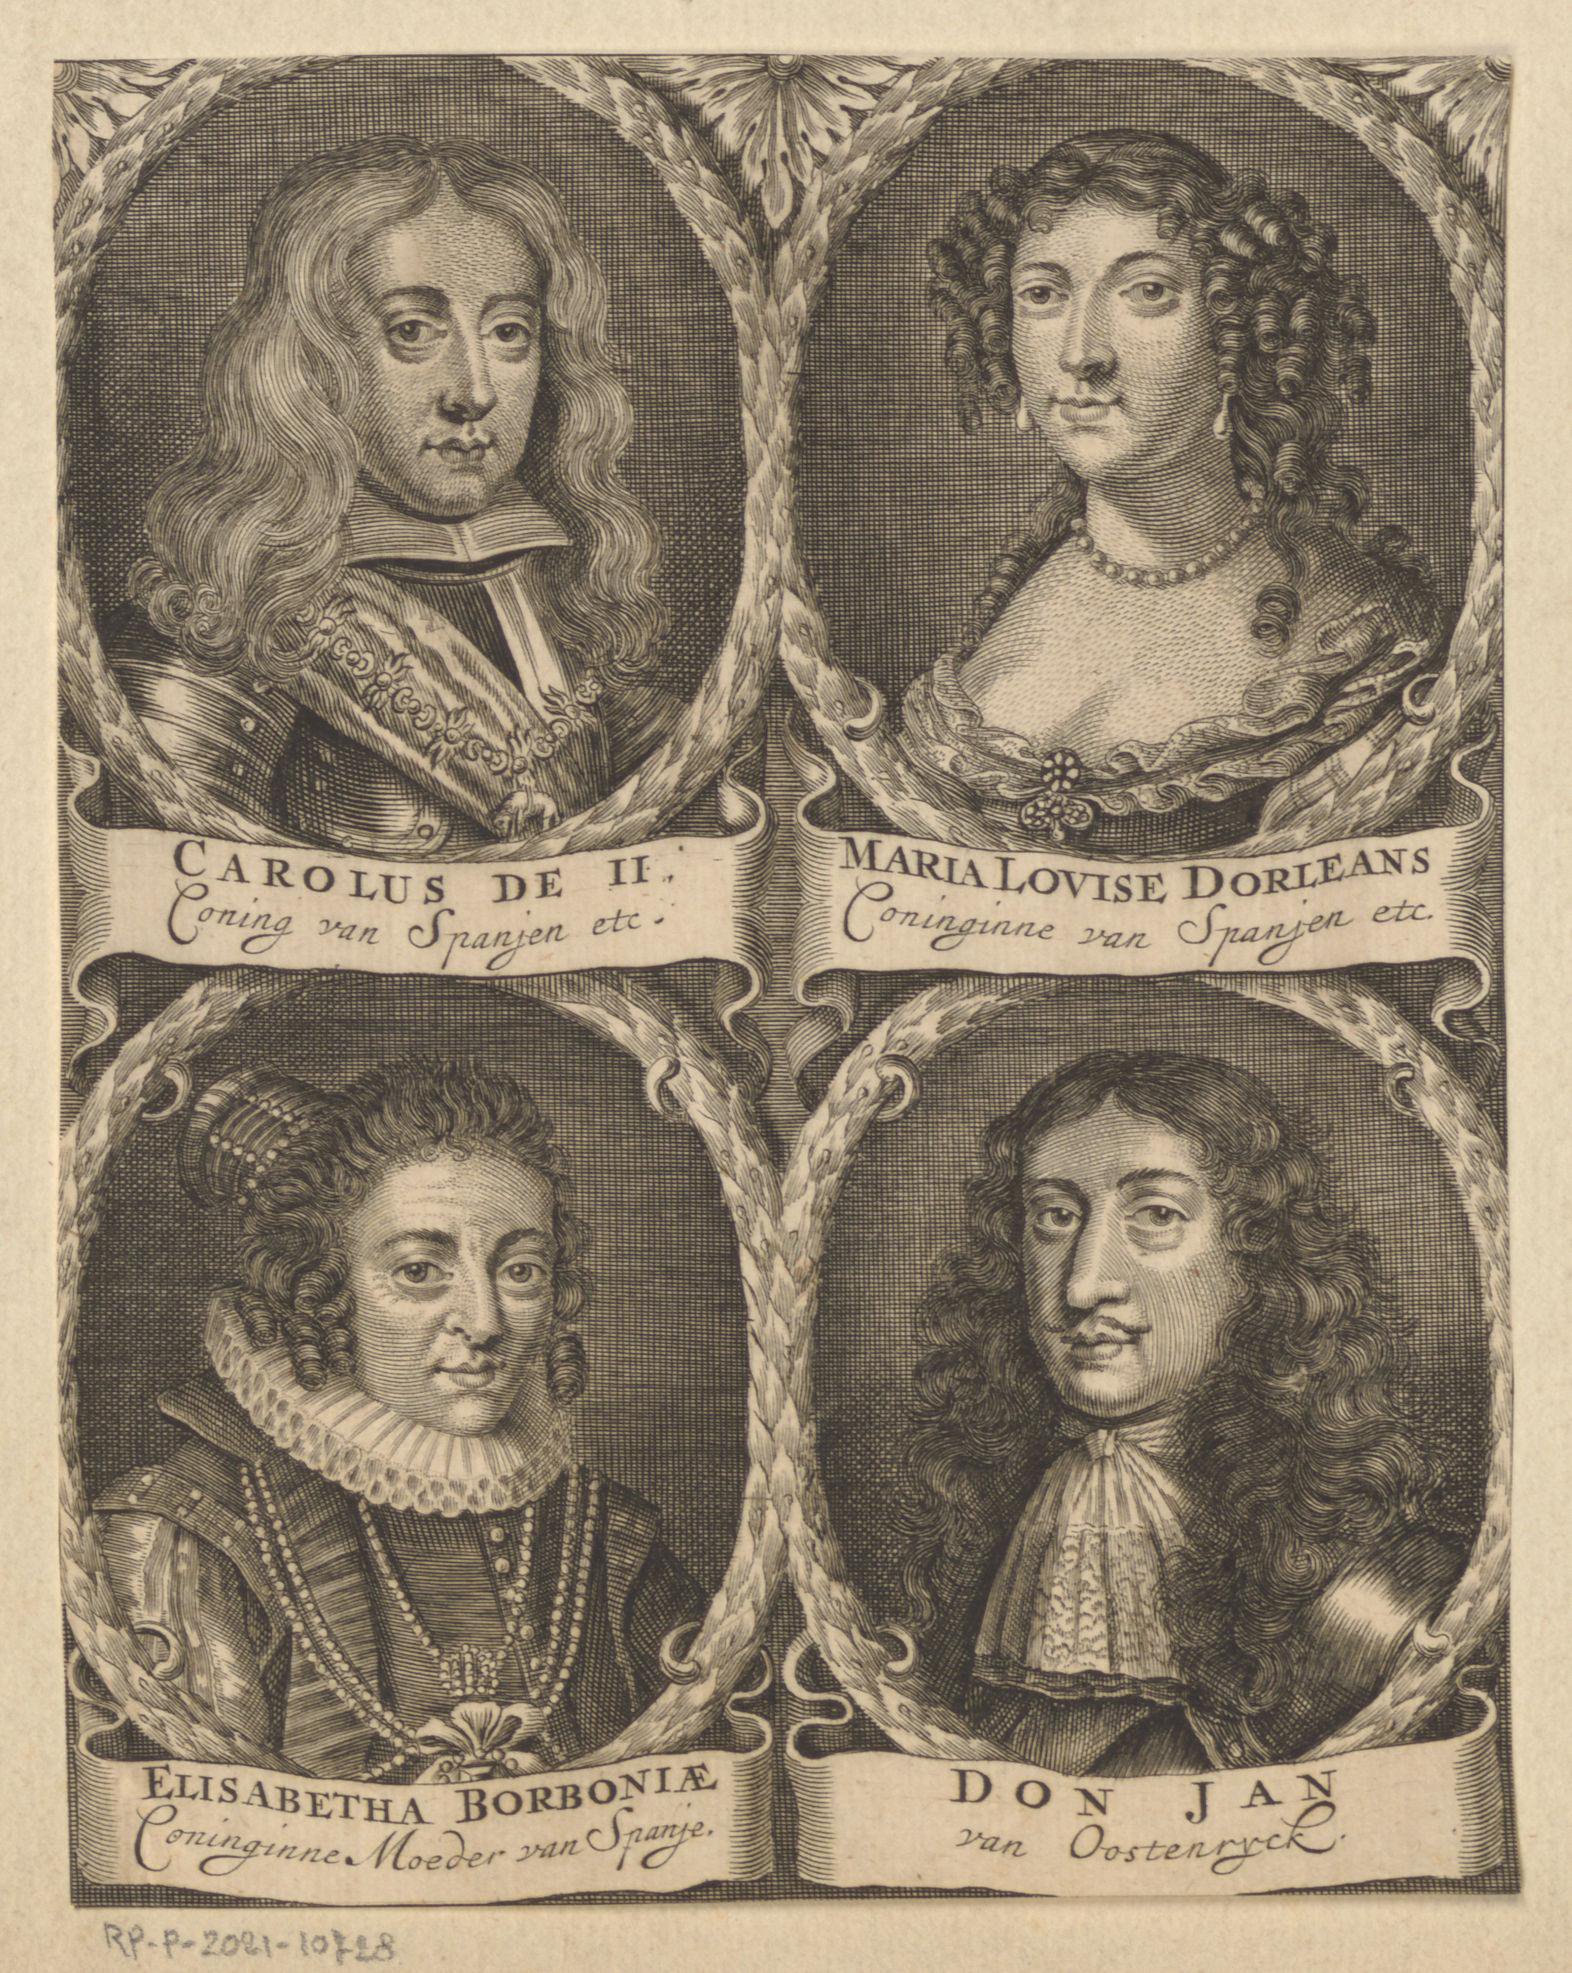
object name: print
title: Portretten van vier koningen en koninginnen van Spanje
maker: Anonymous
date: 1677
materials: paper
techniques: engraving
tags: elisabeth of france (queen of spain and portugal), don juan van oostenrijk, karel ii (koning van spanje), historical persons - bb - woman, queen, king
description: Portretten van Karel II, koning van Spanje, Elisabeth van Frankrijk, koningin van Spanje en Portugal, Marie Louise van Orléans, koningin van Spanje en Don Juan van Oostenrijk.